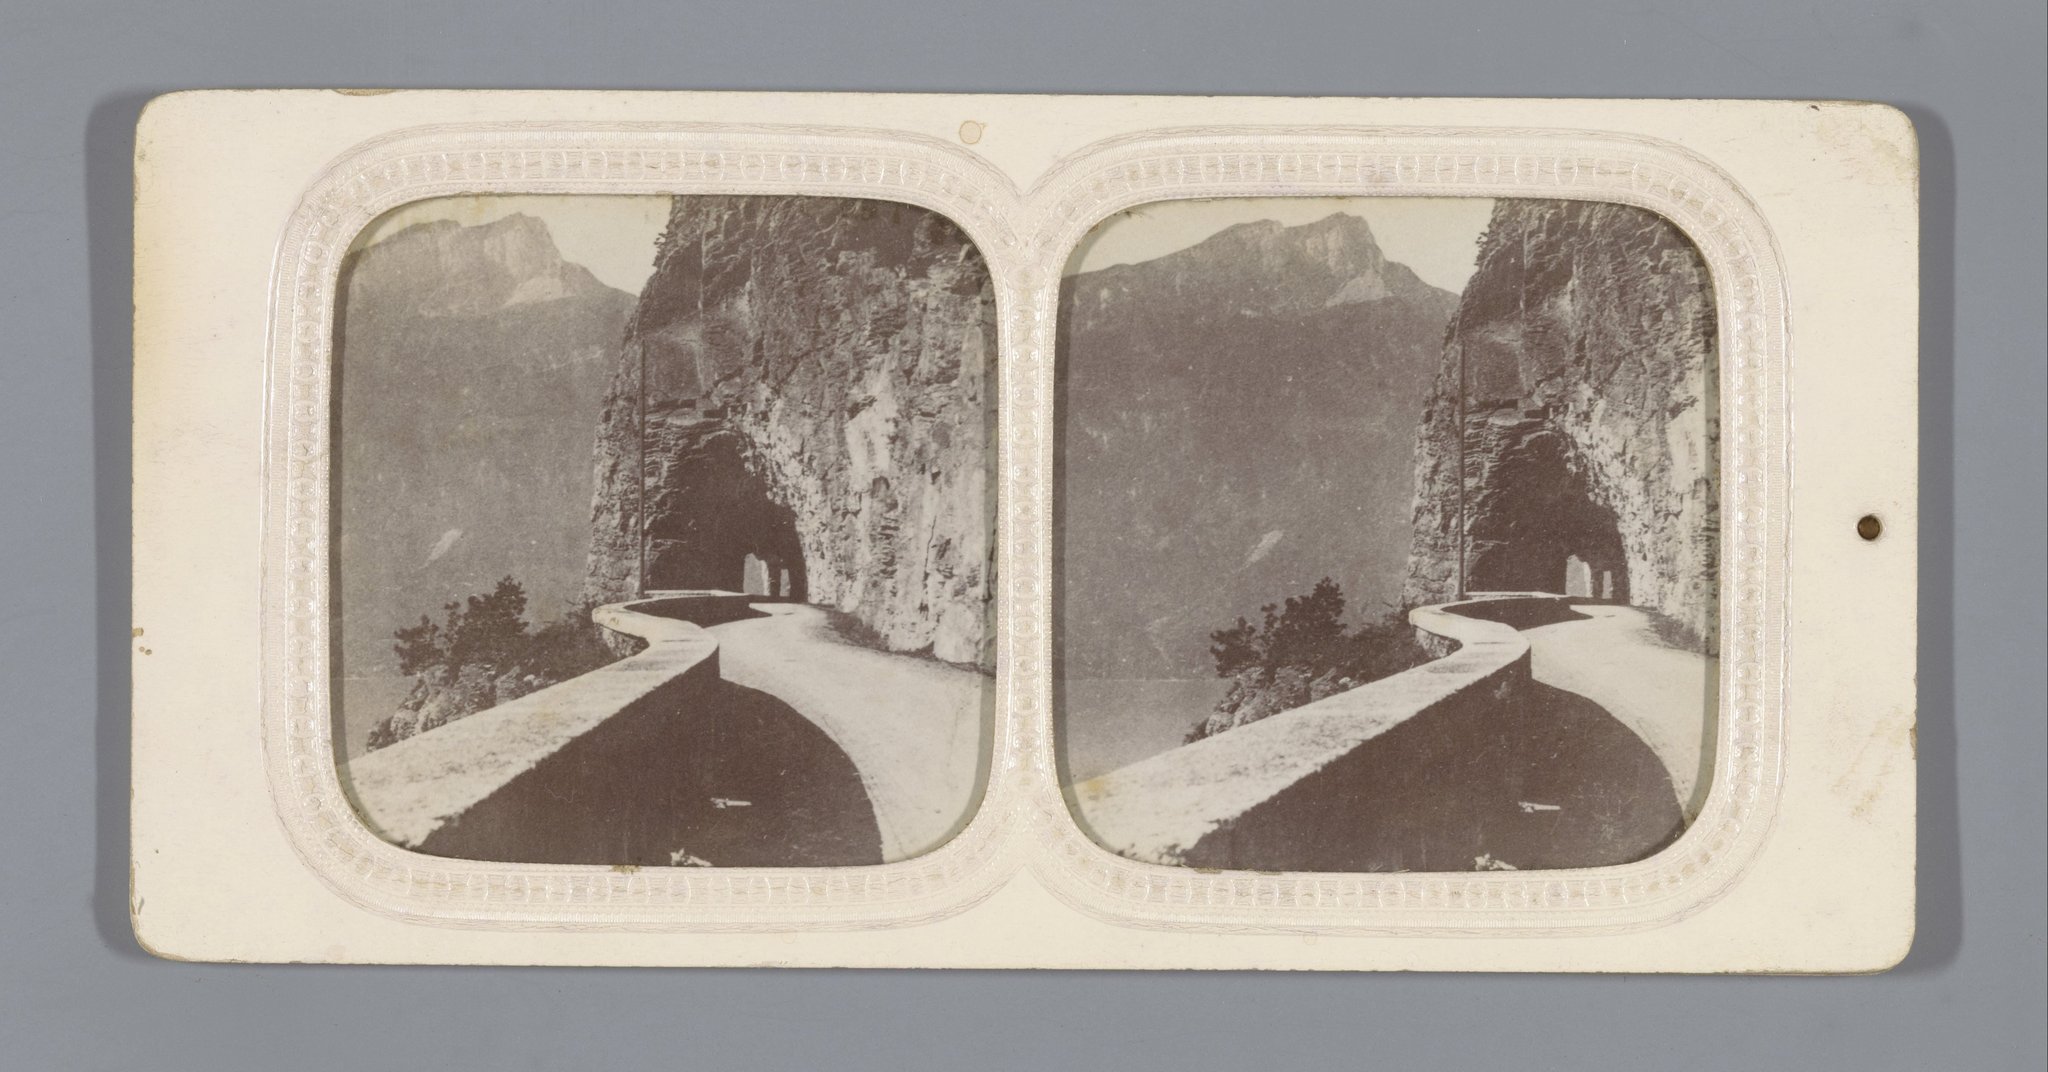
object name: tissue stereograph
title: Bergpas en tunnel in Zwitserland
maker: Anonymous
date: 1855-1875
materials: cardboard, paper, photographic support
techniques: albumen print, hand coloring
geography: switzerland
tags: underground road, tunnel, mountains, switzerland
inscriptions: inscription: ‘x’